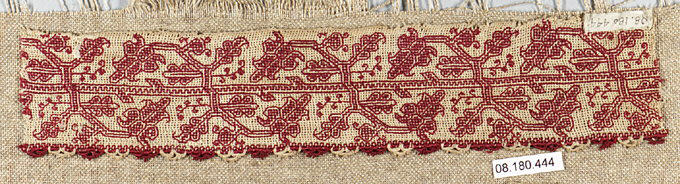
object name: border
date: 1501-1600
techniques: embroidery